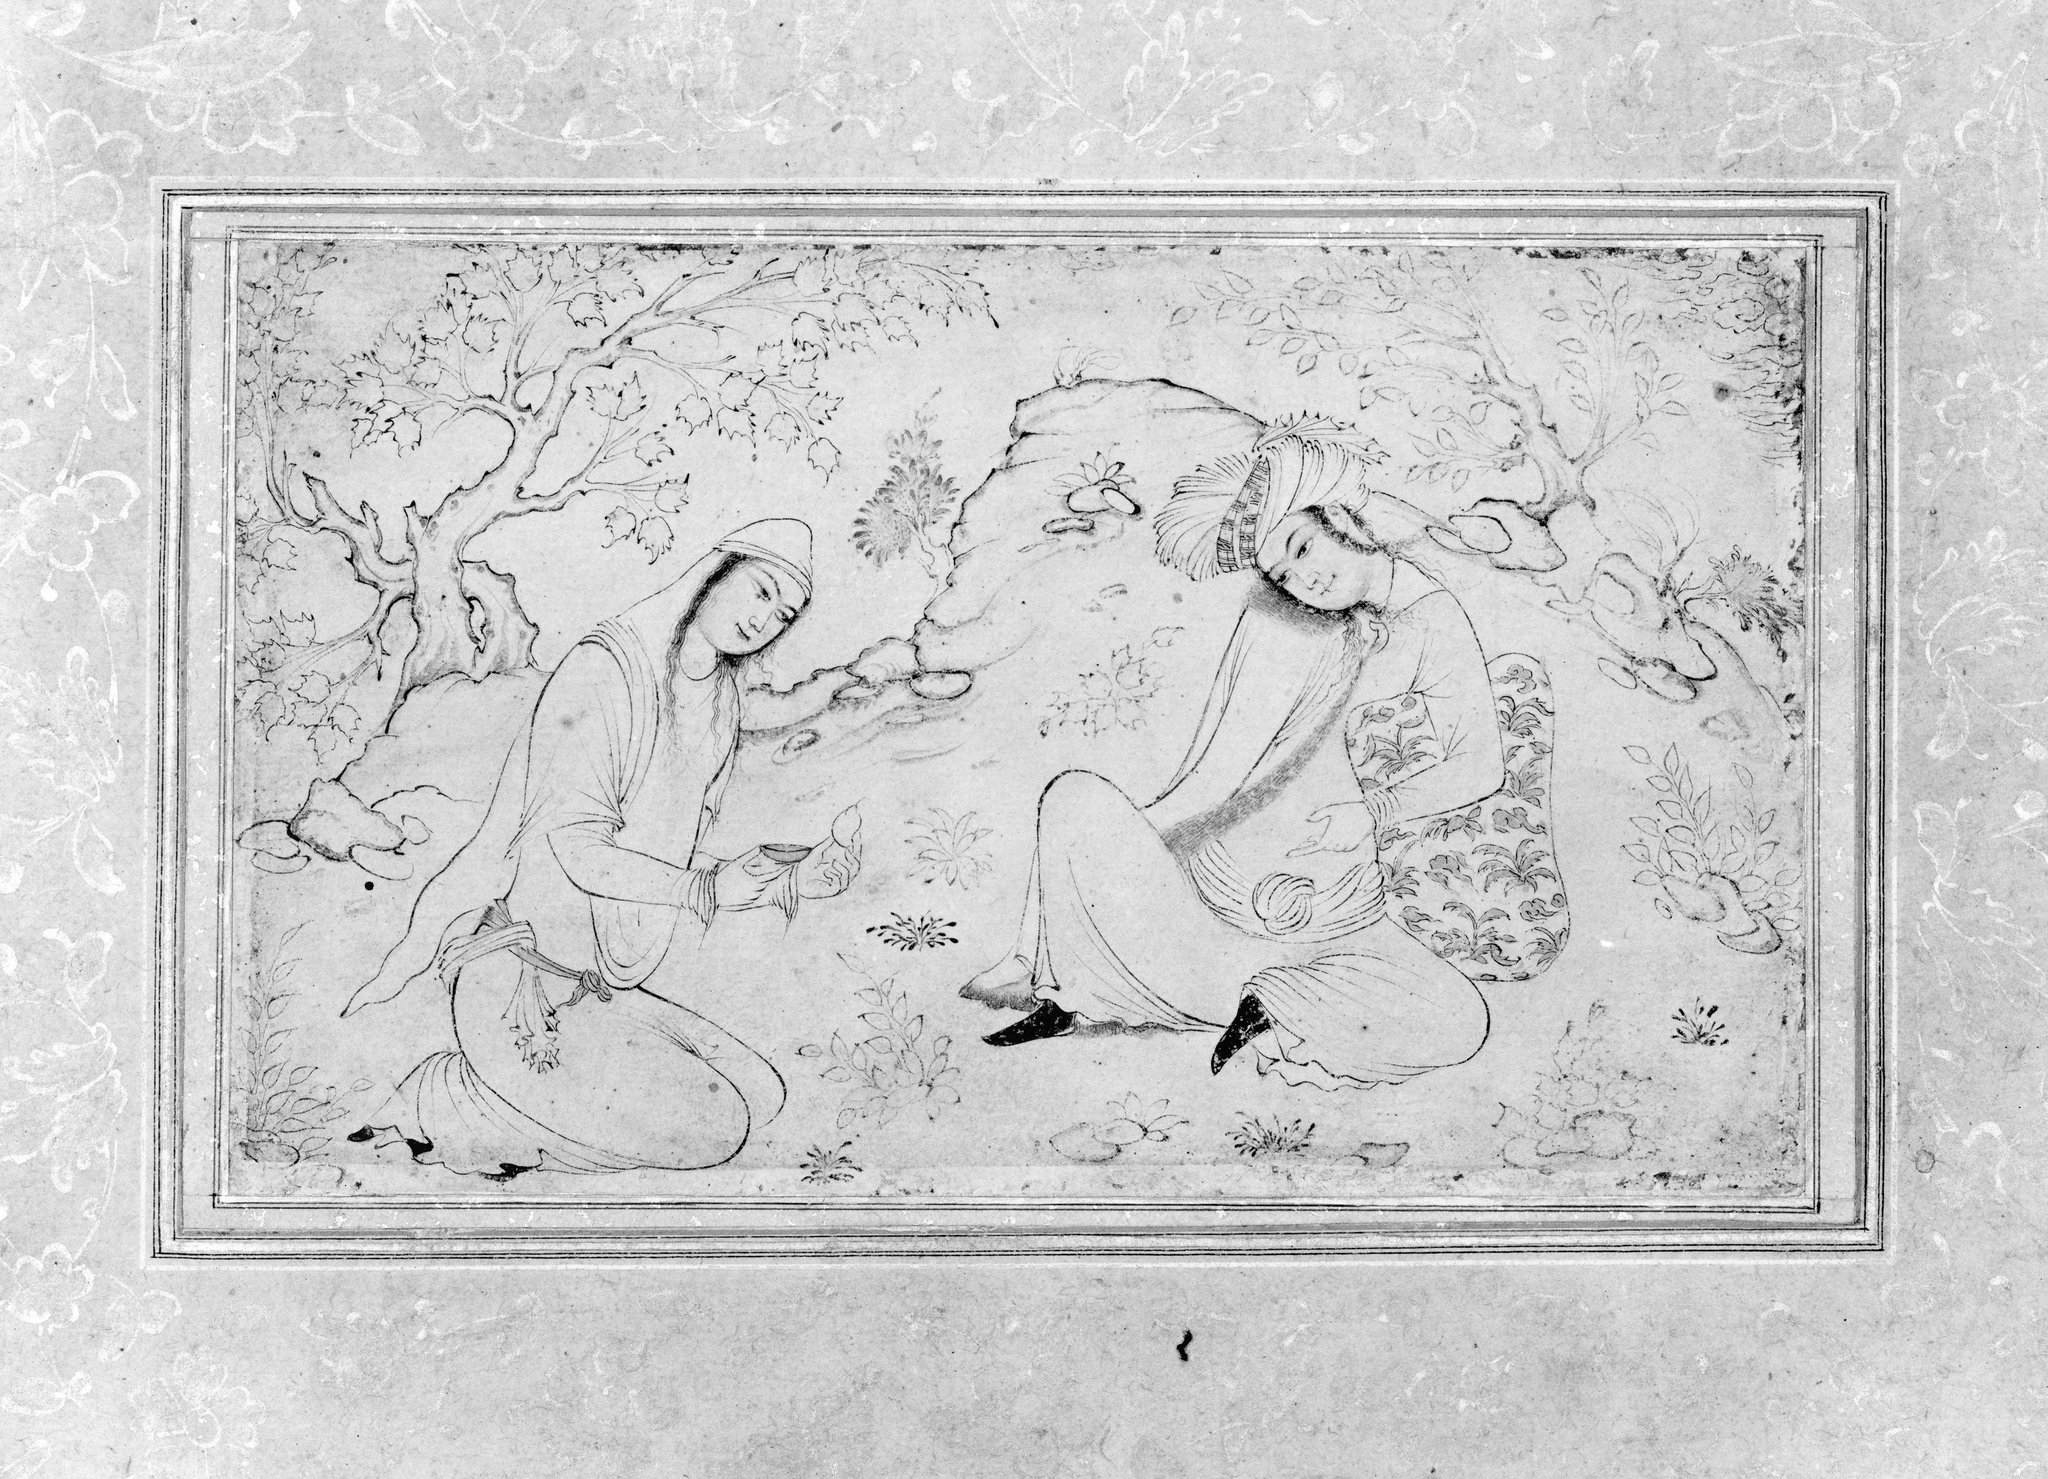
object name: illustrated album leaf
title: Young Man and Woman in a Landscape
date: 1601-1650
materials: gold, ink, paper, watercolor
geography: iran